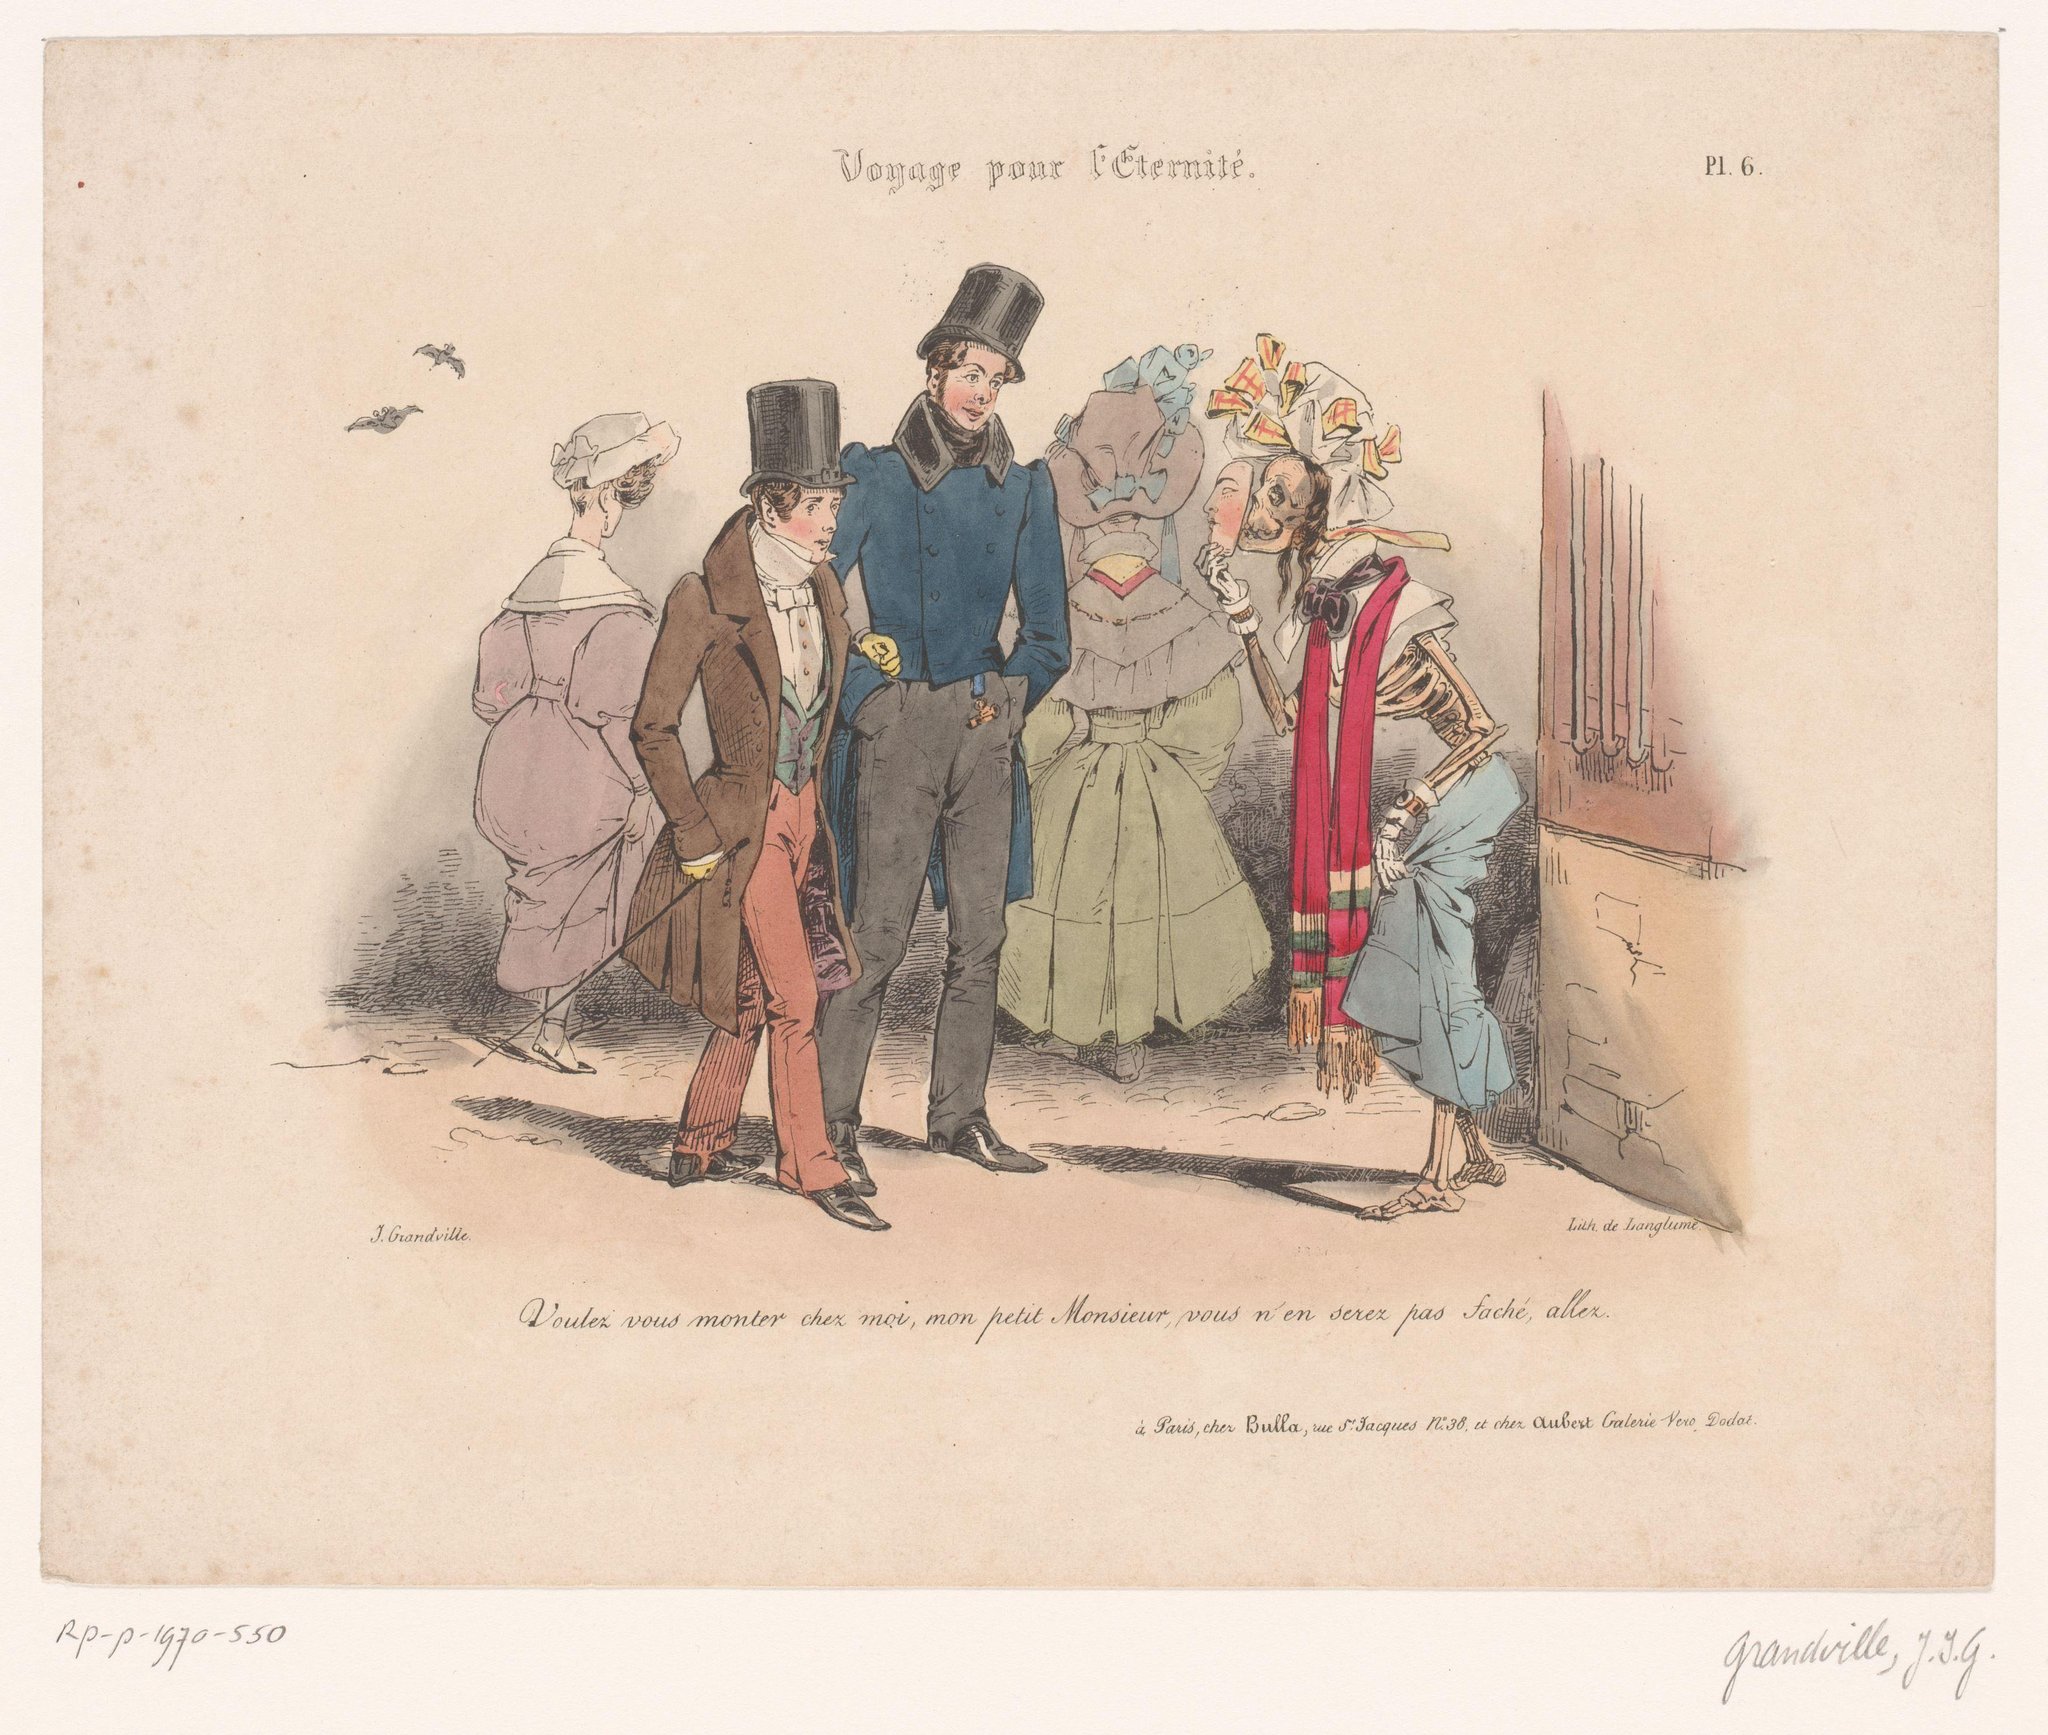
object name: cartoon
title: Twee jongemannen ontmoeten de gemaskerde Dood op straat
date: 1830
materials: paper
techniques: hand coloring, lithograph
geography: paris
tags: mask, 'sudden death', death as skeleton, youth, adolescent, street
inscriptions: collector's mark: Lugt 2228a